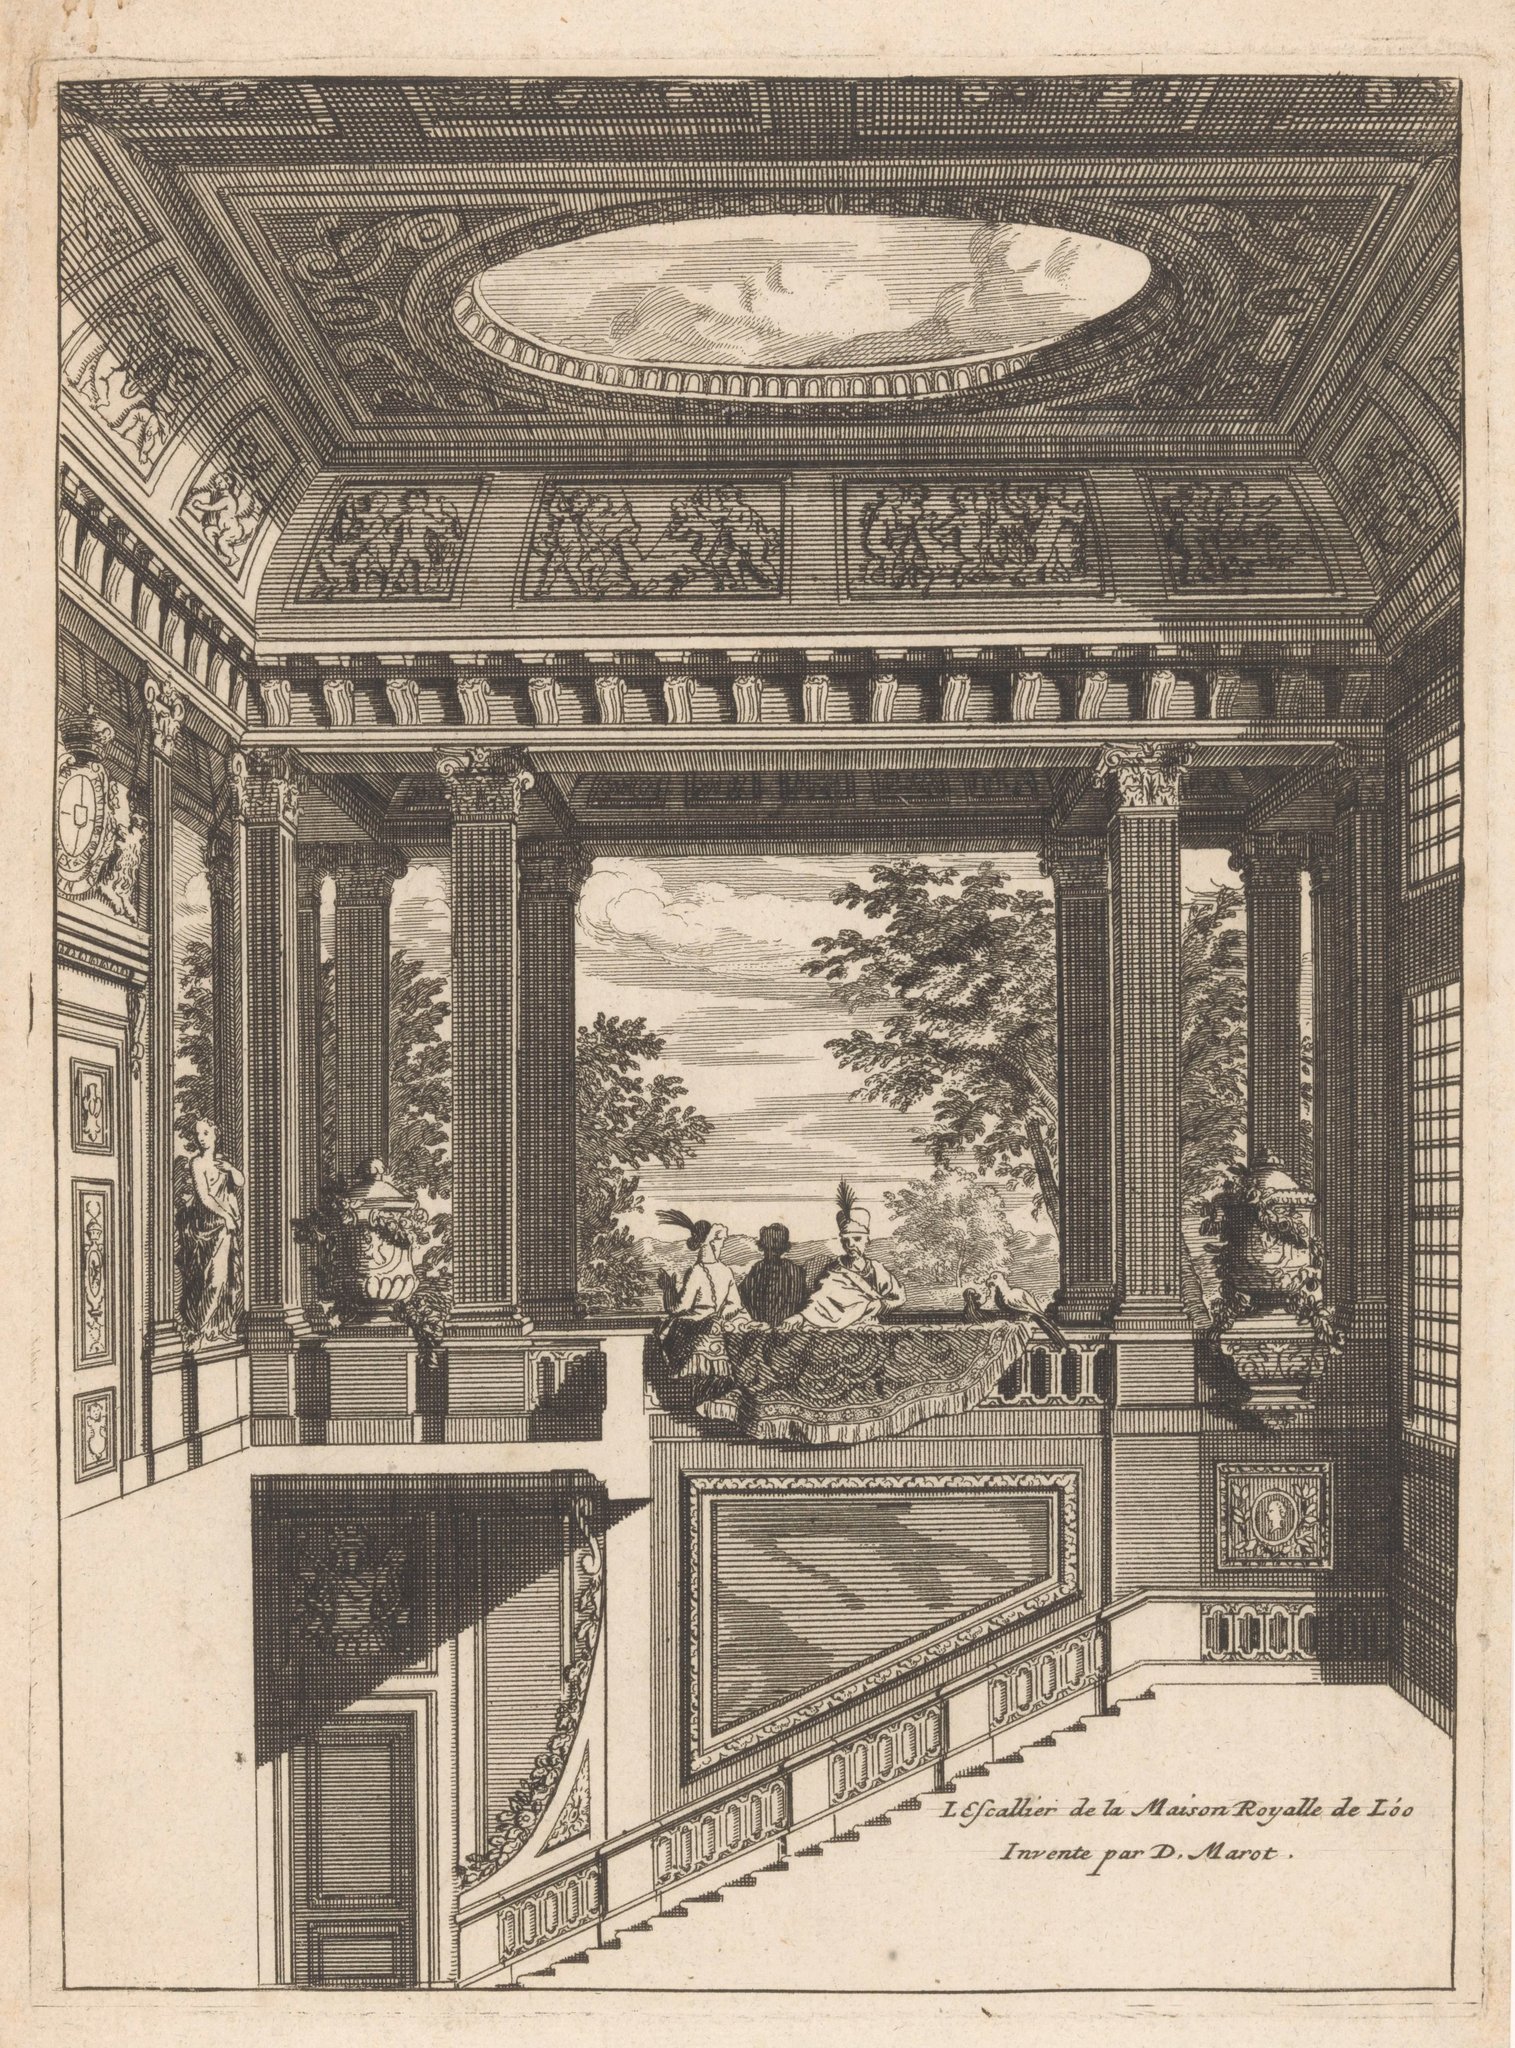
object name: print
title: Trompe-l'oeil decoratie voor trappenhuis van Paleis Het Loo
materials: paper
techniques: etching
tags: 'trompe l'oeil', staircase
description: Decoratie voor het trappenhuis van Paleis het Loo met balustrade, gecanneleerde zuilen en een oculus in het plafond.